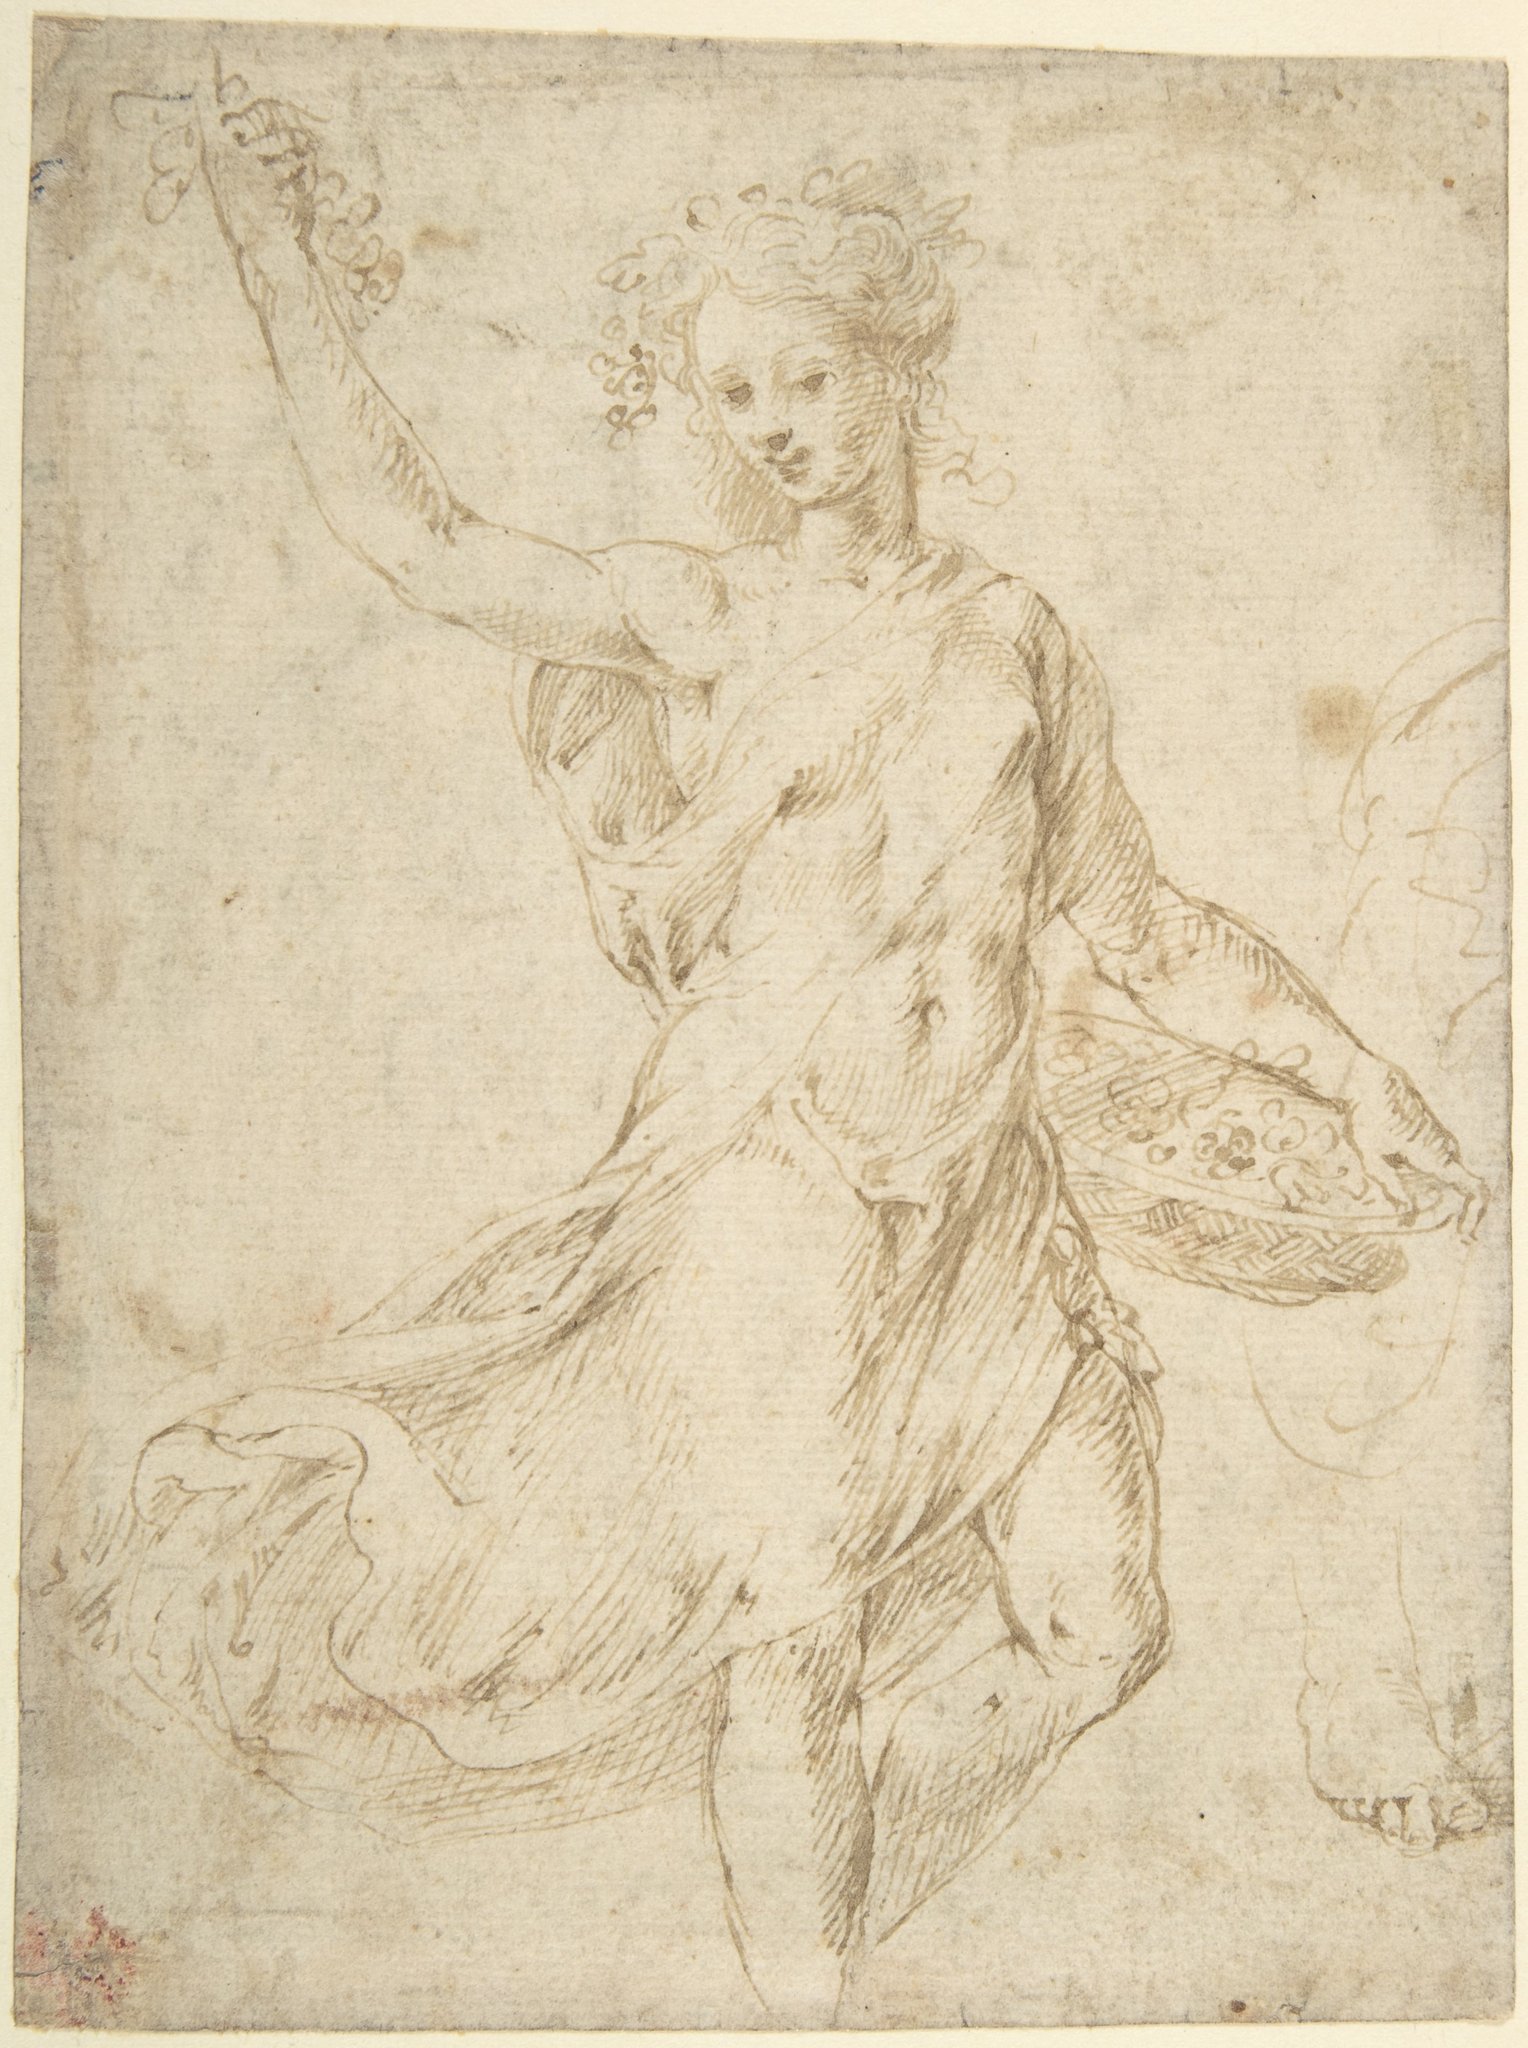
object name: drawing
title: Flora (recto); Mountainous Landscape with Buildings (verso)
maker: anonymous, italian, 16th century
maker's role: artist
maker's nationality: italian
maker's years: 1550-1600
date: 1501-1600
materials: ink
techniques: pen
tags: women